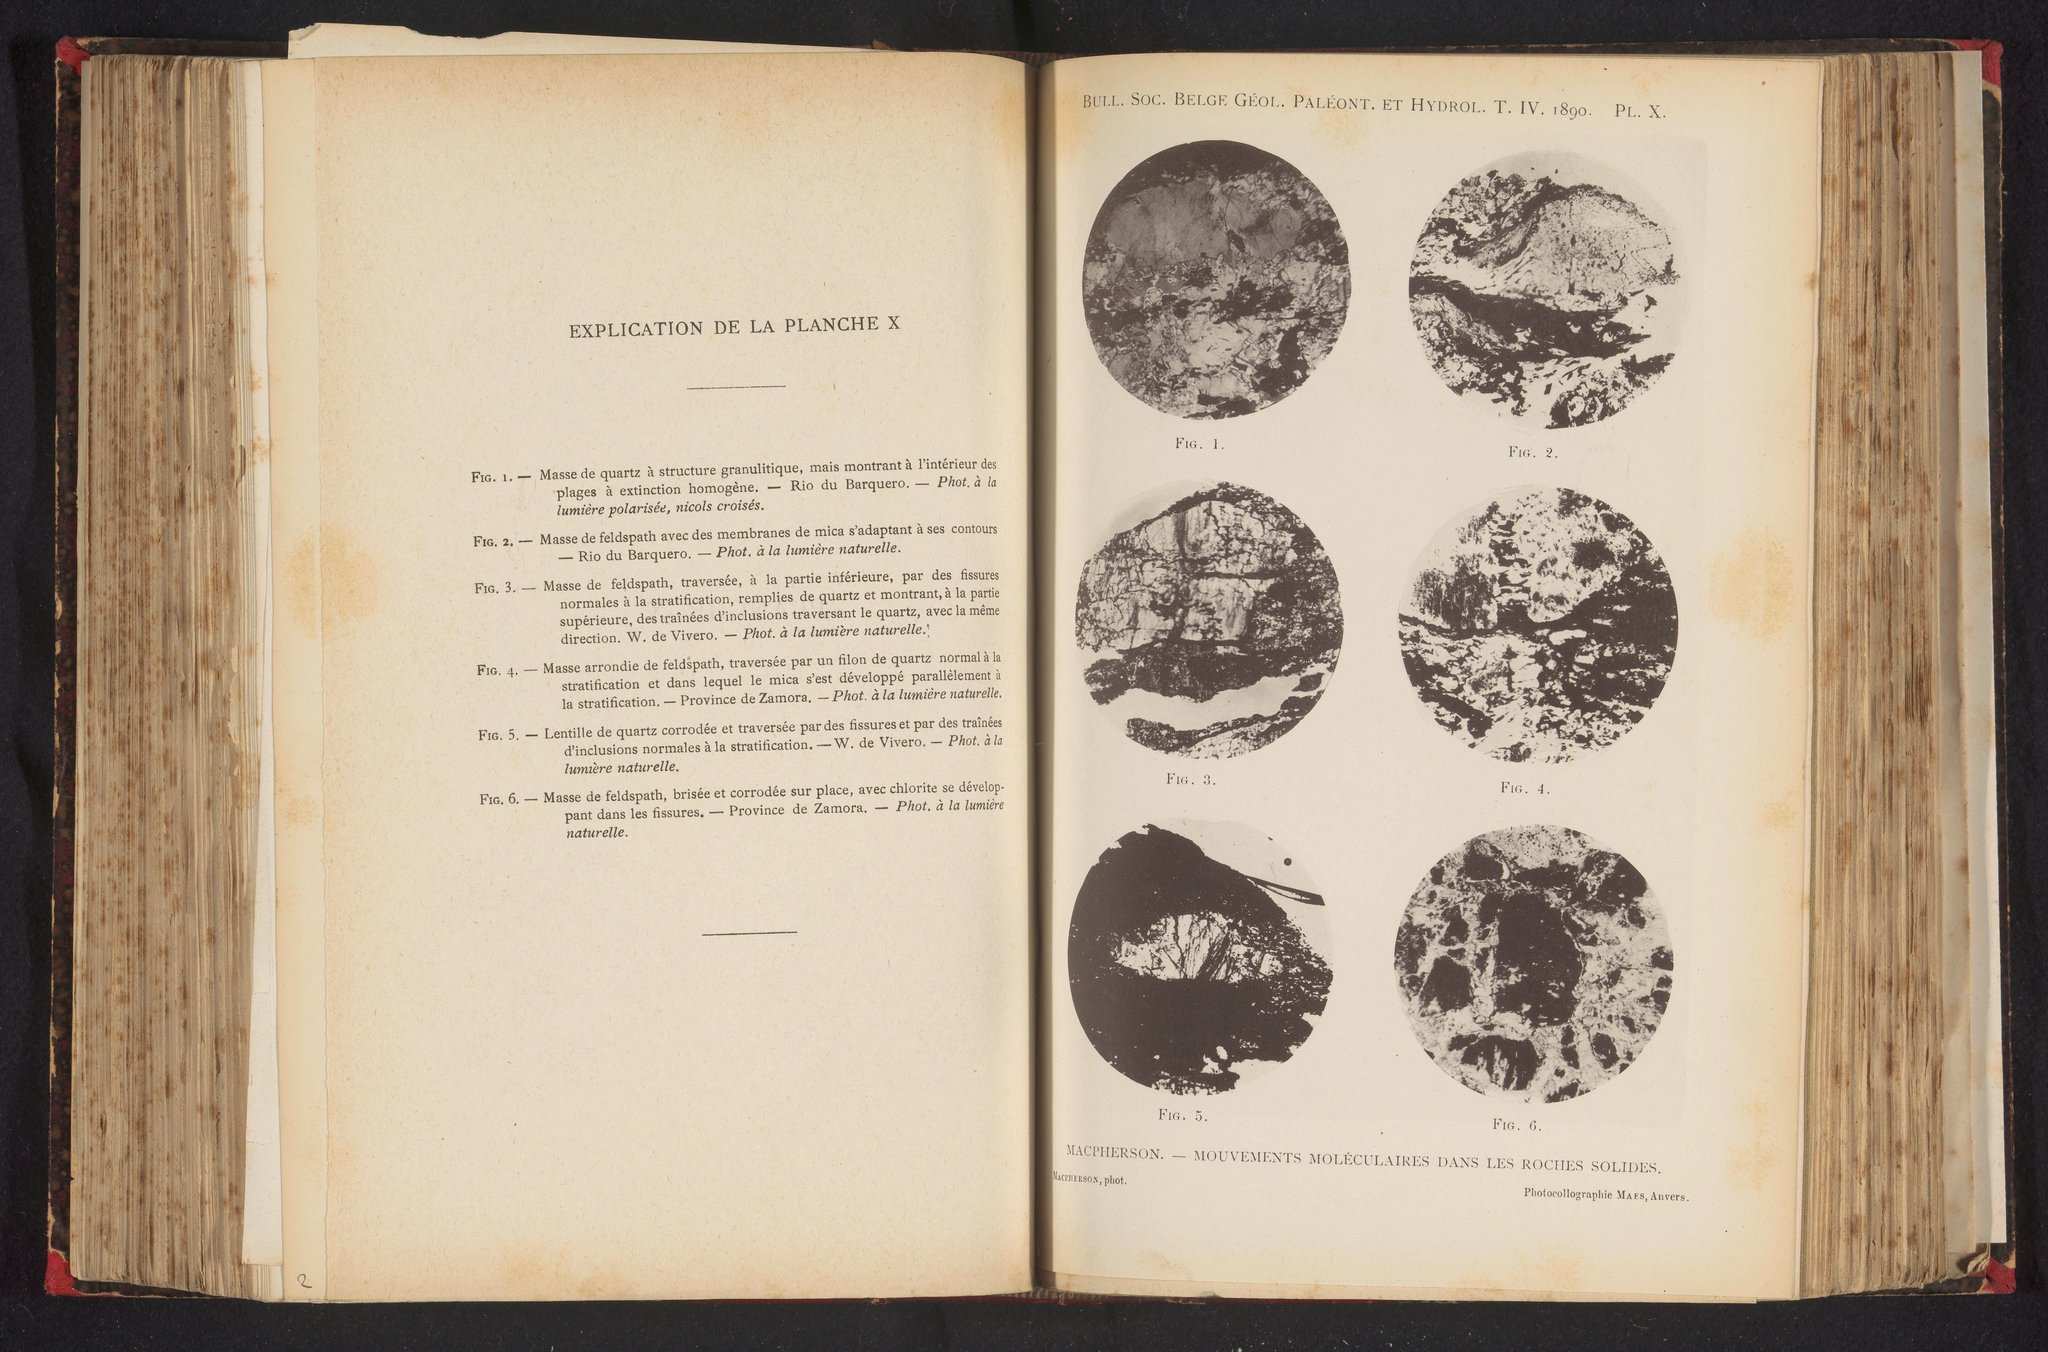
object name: photomechanical print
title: Macpherson. Mouvements moléculaires dans les roches solides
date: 1885-1890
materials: paper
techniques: autotype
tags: geology, rocks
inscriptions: inscription: ‘Macpherson, phot.’, inscription: ‘Bull. Soc. Belge de Géol. de Paléont. et Hydrol. T. IV. 1890. l. X’